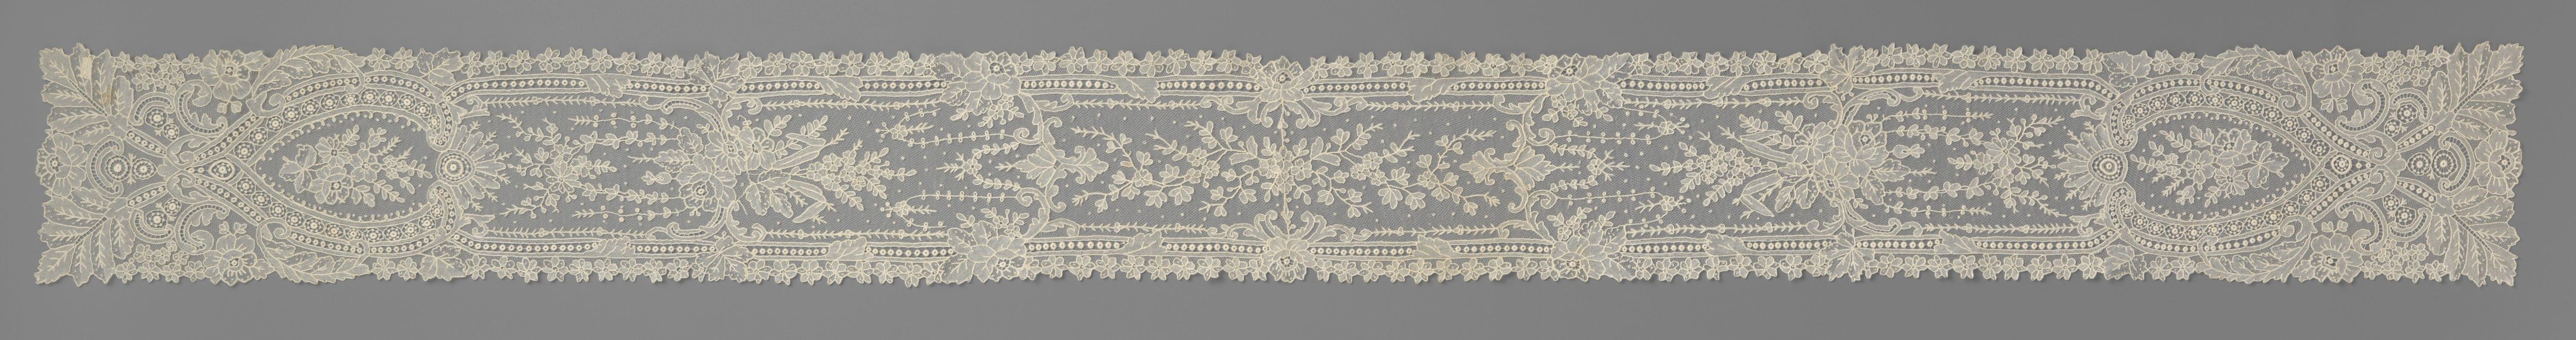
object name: headdress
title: Barbe of hoofdtooi van naaldkant met treurwilgenblaadjes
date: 1860-1880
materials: linen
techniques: needle lace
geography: brussels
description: Een zuivere rechthoek vertoont een eindeloze tak van fijne treurwilgenblaadjes binnen een parellijstje en een snoer van rozetjes. In de uiteinden is de parellijst in een hartvorm gelegd die een tuiltje roosjes en margrietjes omkranst. In de hoeken staan grote eikebladeren. Bladvoluten oversnijden de parellijst en verdelen het vlak in compartimenten met bloemtakjes. Point de gaze de Bruxelles.